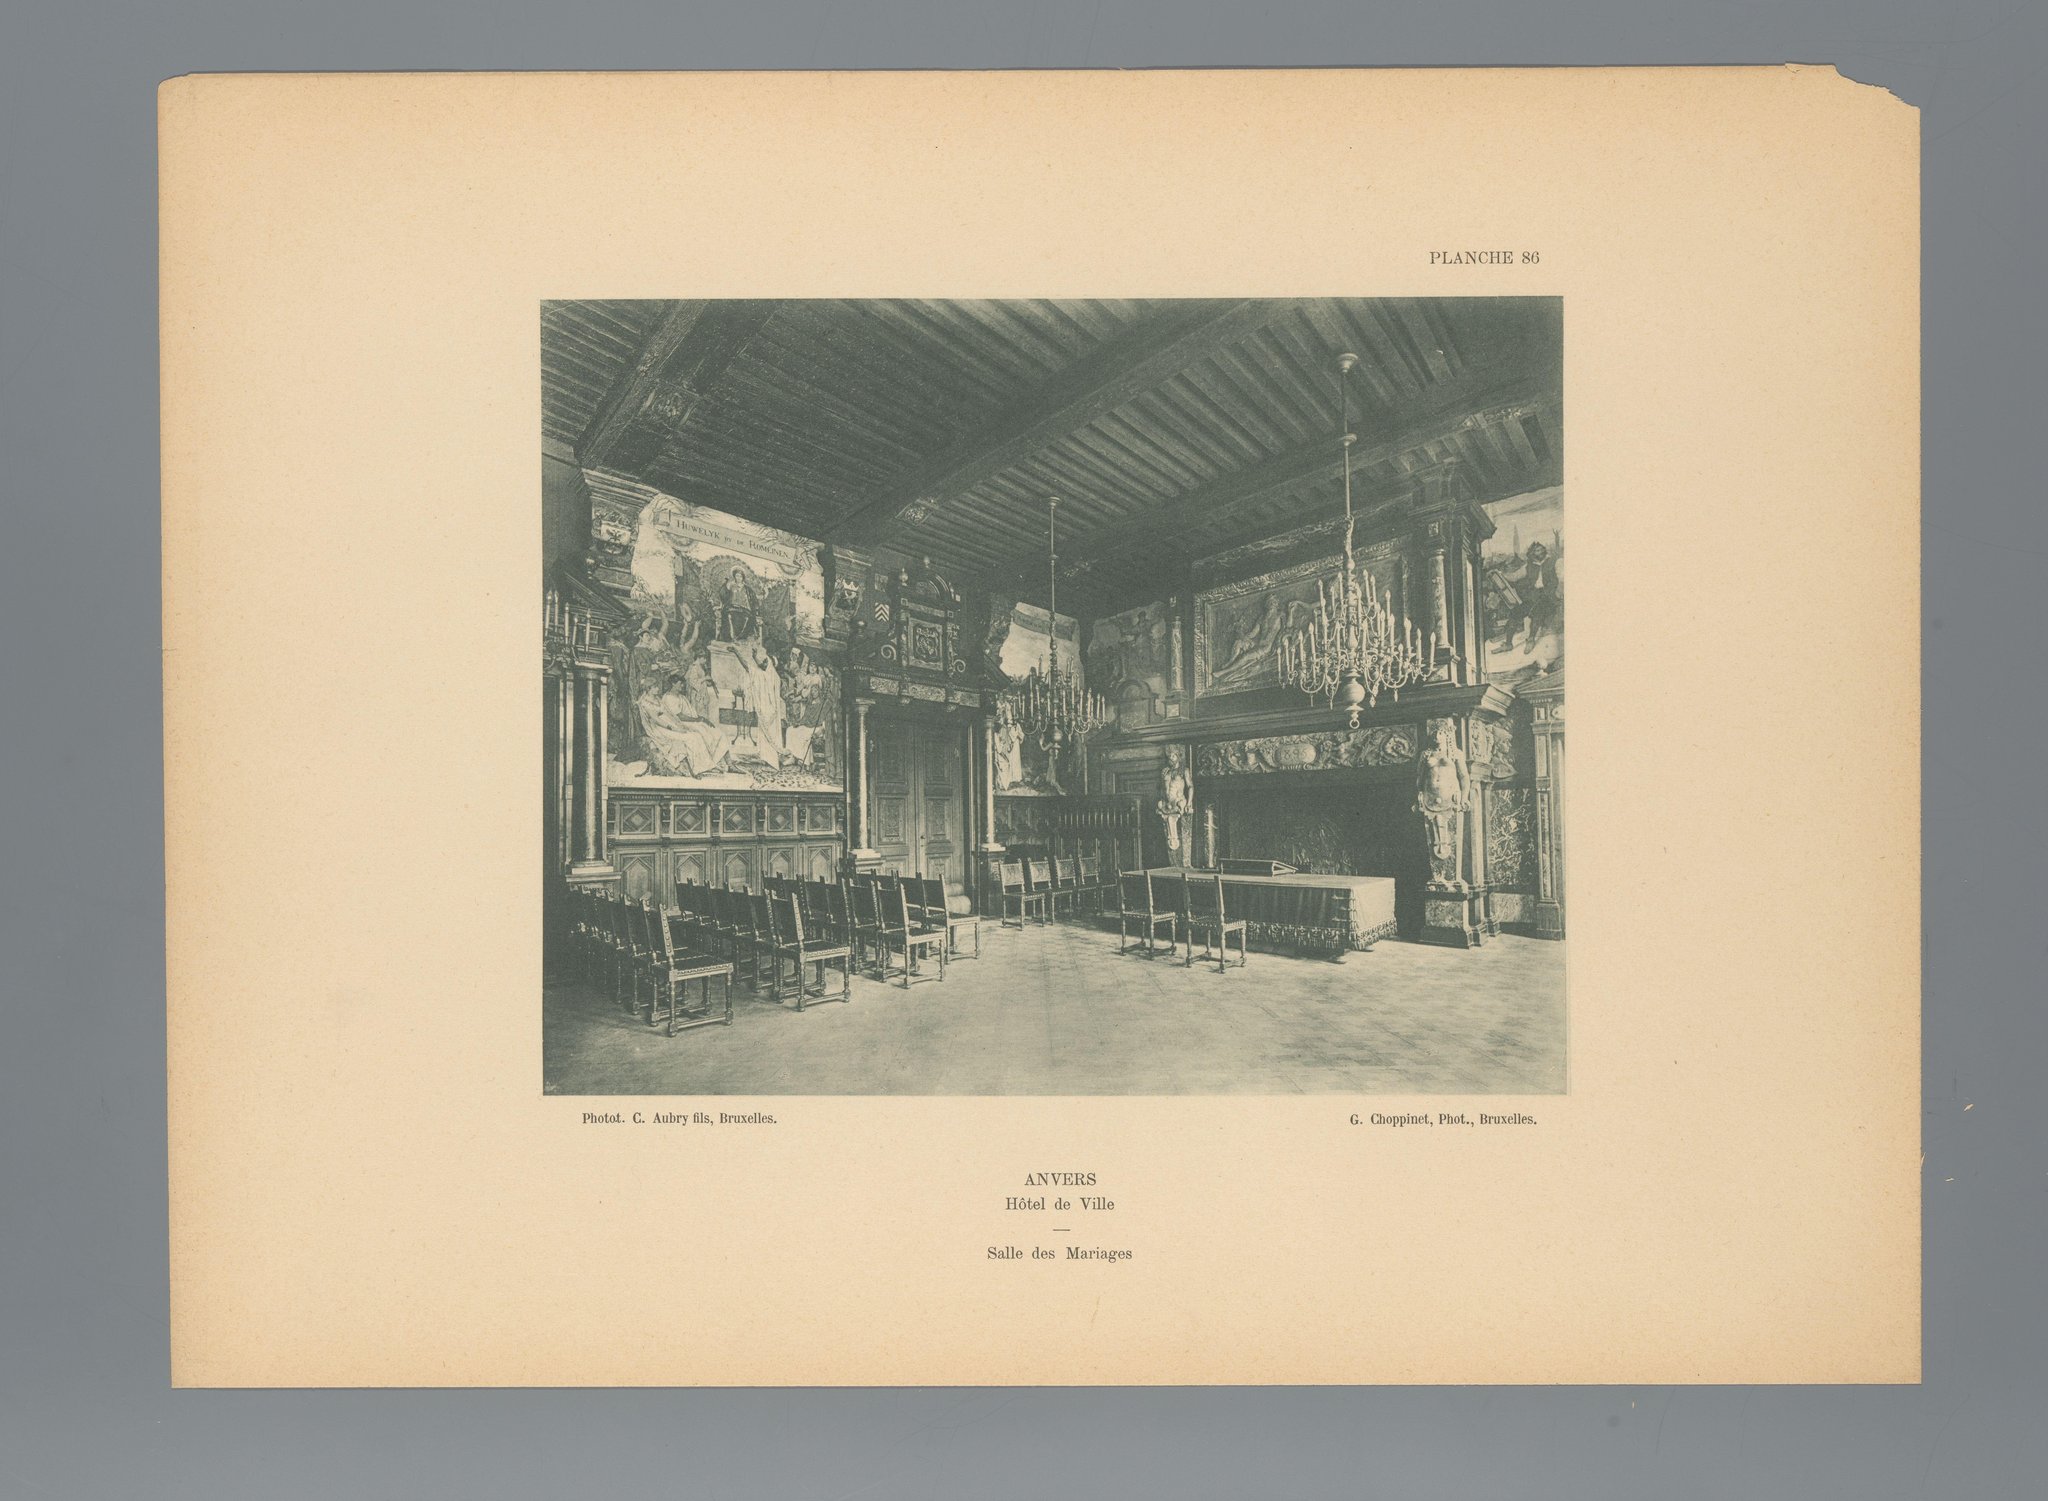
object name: photomechanical print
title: Gezicht op de trouwzaal van het stadhuis van Antwerpen, België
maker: gustave choppinet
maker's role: fotograaf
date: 1893-1898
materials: paper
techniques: photograph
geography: antwerp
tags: civil marriage ceremony, townhall, other rooms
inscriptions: number: ‘PLANCHE 86’, inscription: ‘Hôtel de Ville/ Salle des Mariages’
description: Deze prent maakt deel uit van een omslag met 89 prenten en 5 tekstbladen.